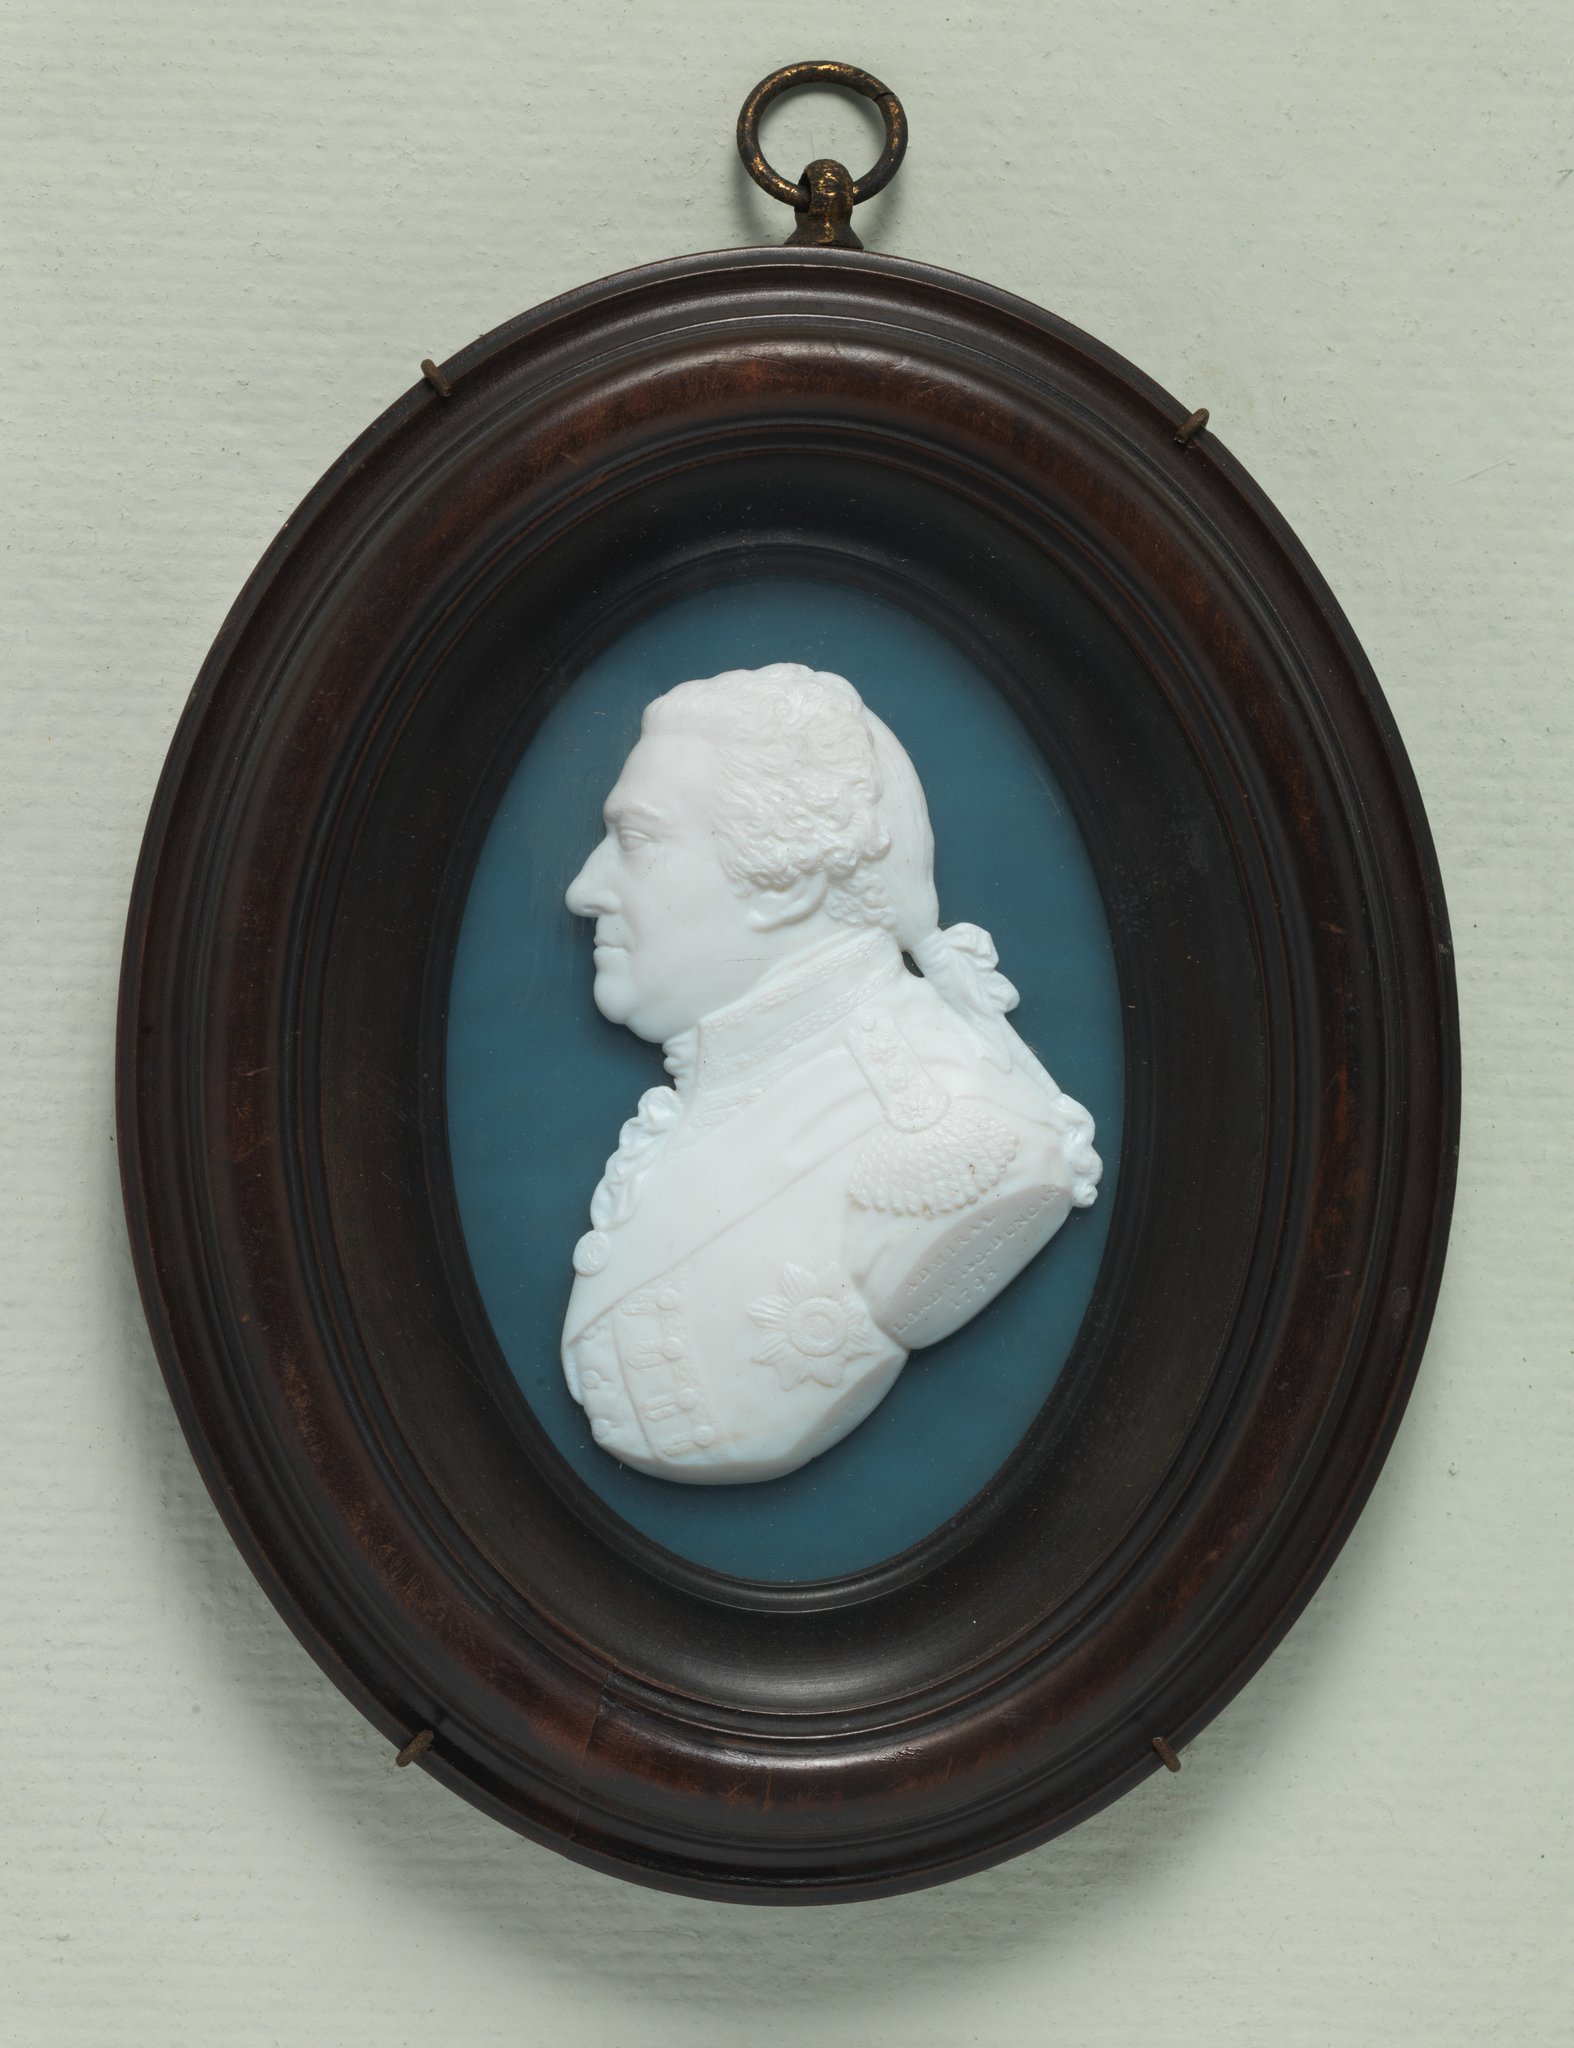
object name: portrait plaque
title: Admiral Lord Duncan of Camperdown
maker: william tassie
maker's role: maker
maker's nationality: british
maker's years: 1777-1860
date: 1798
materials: glass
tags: men,profiles